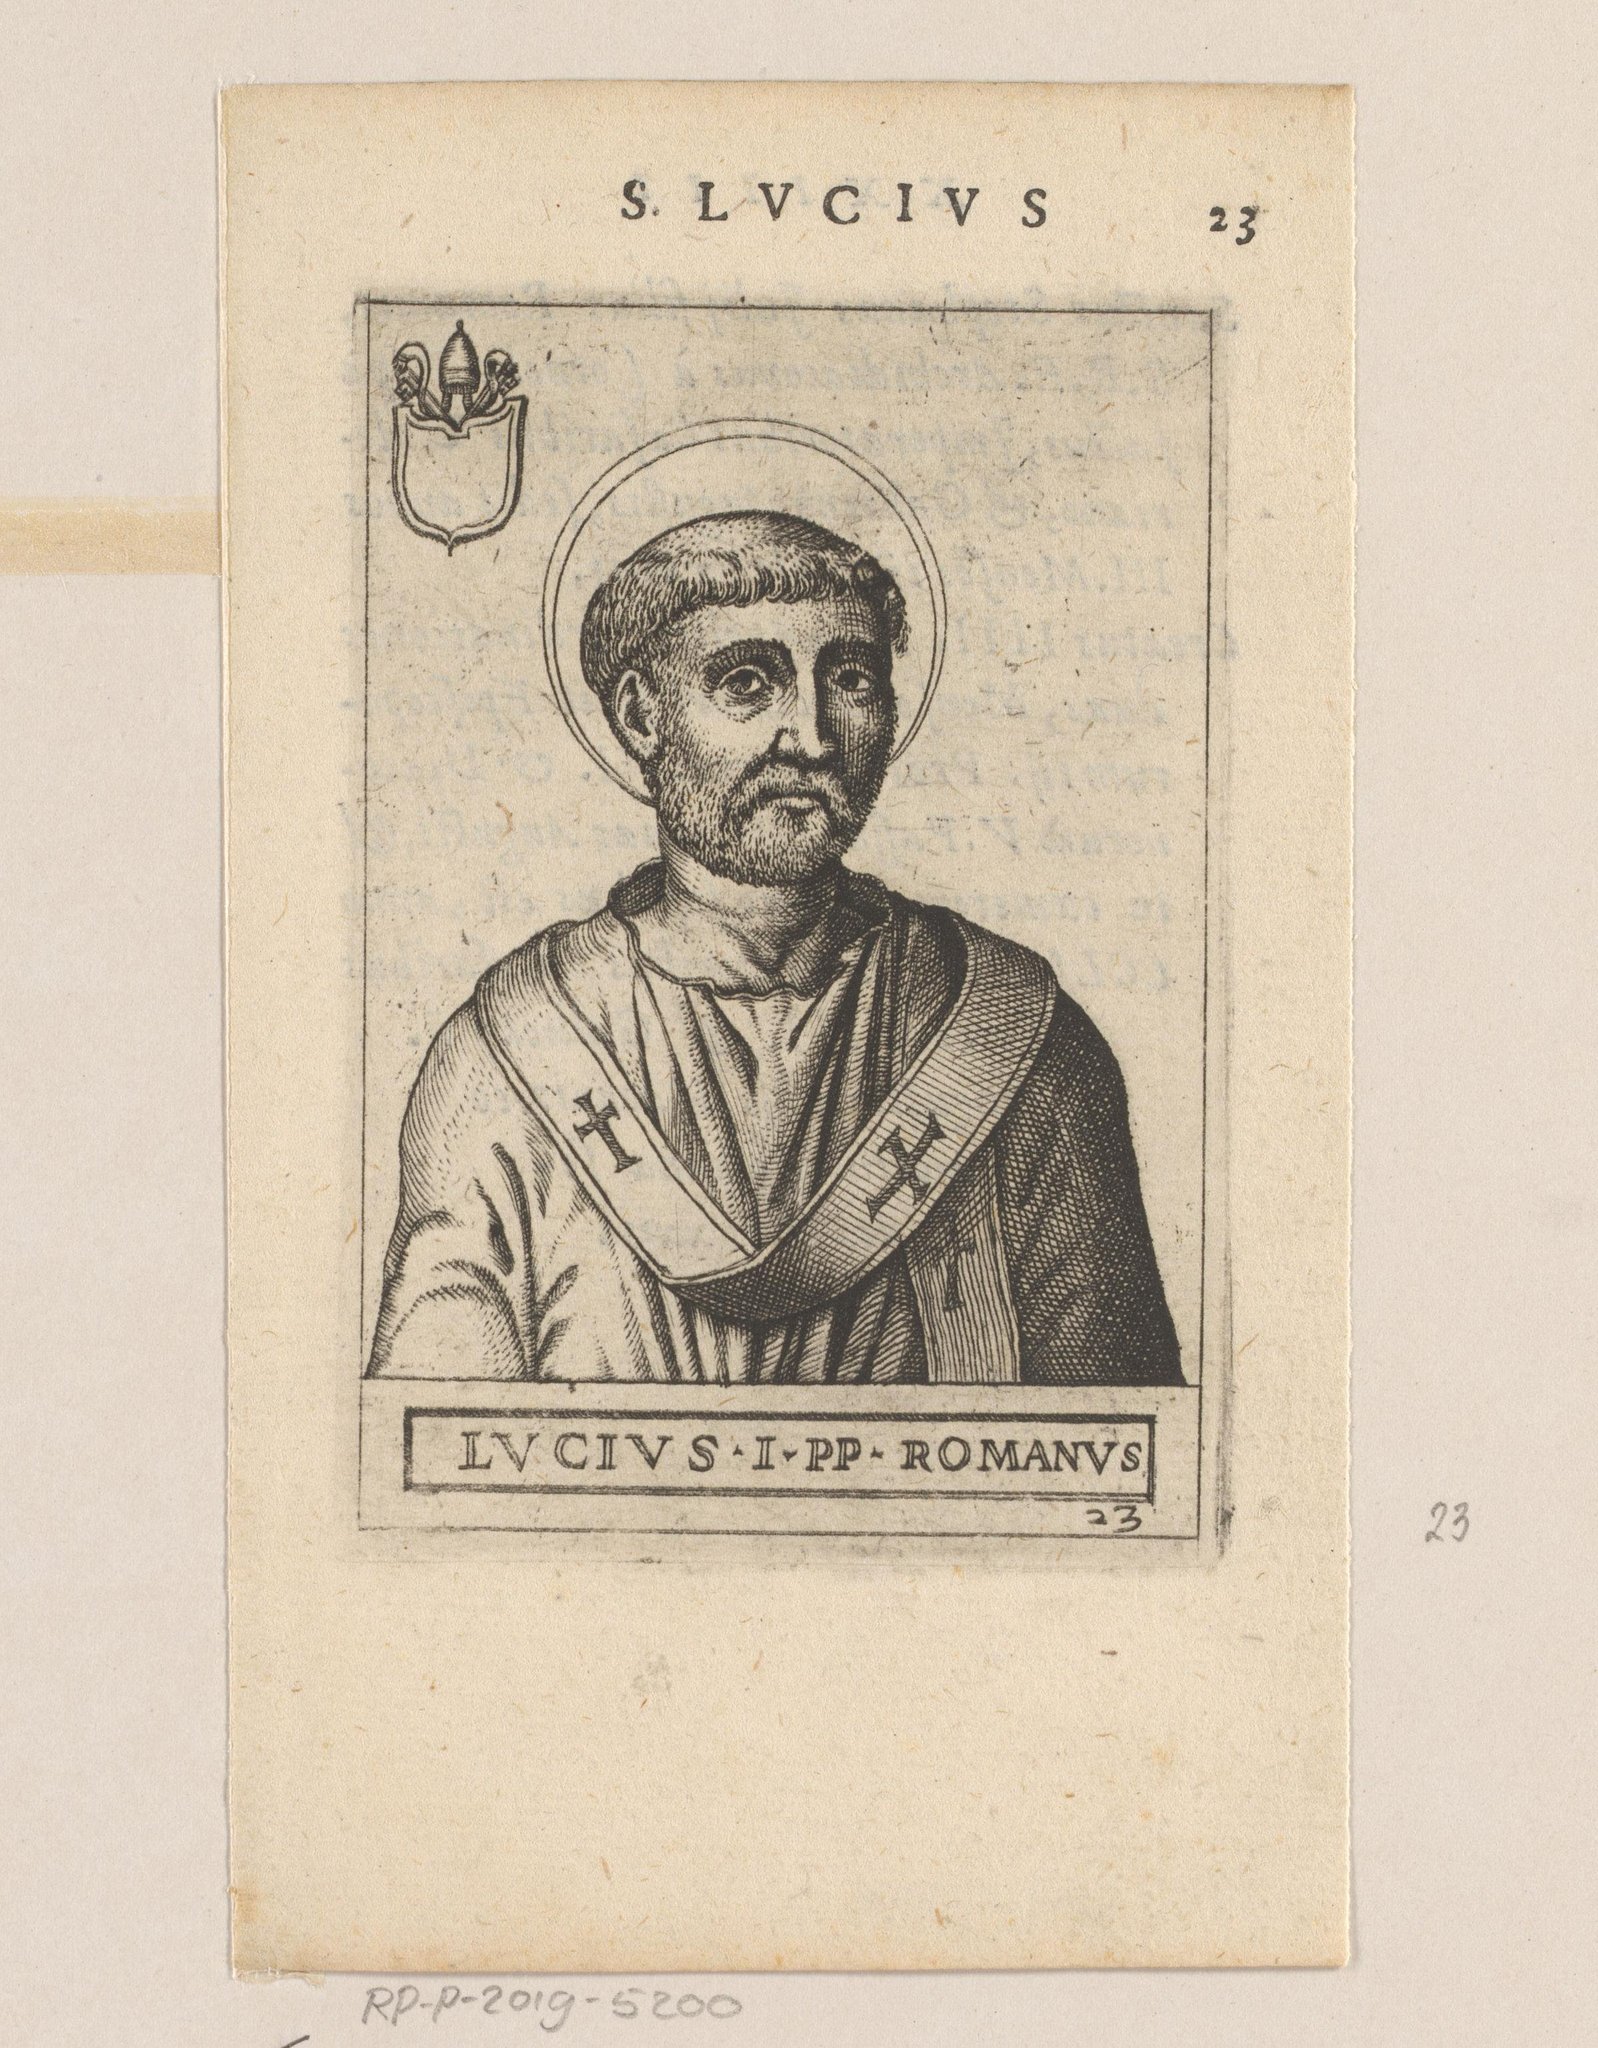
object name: book illustration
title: Portret van paus Lucius I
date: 1595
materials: paper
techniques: engraving, letterpress printing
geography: rome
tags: historical persons, pope, armorial bearing, heraldry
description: Prent uit: Cavalieri, Giovanni Battista de'. Effigies pontificum romanorum cum eorum vitis (...). Rome: Bartolomeo Bonfadino, 1595. Prent voor het eerst verschenen in: Cavalieri, Giovanni Battista de'. Pontificum romanorum effigies (...). Rome: Domenico Basa en Francesco Zanetti, 1580. Prent ook gebruikt in latere publicaties.